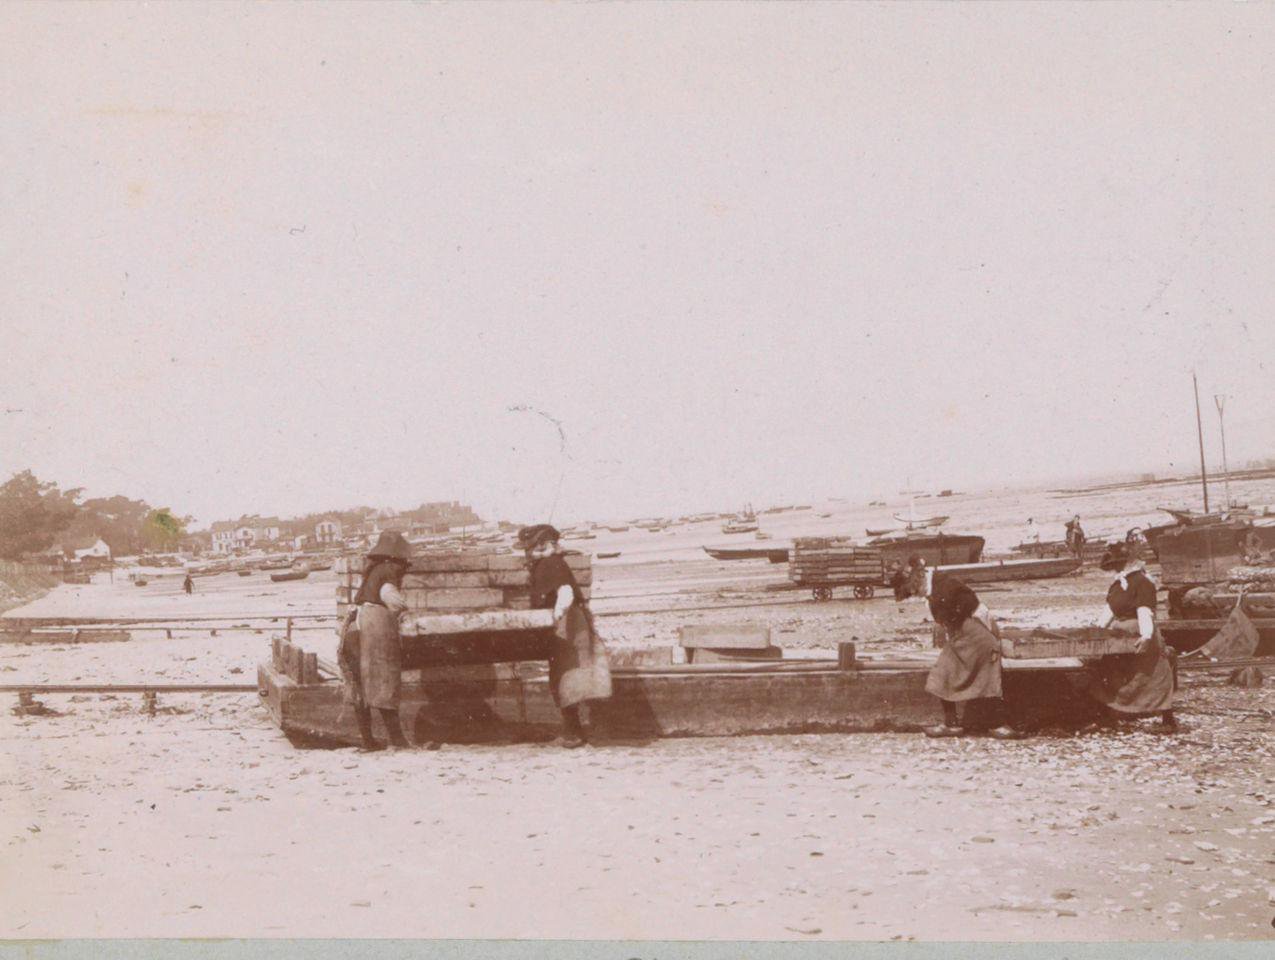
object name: photograph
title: Vissersvrouwen sjouwen (vermoedelijk) bakken met vangst op het strand bij Arcachon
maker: delizy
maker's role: manufacturer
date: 1803-1897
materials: paper, photographic support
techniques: gelatin silver print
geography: arcachon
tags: rowing-boat, canoe, etc., beach, fisherman, ships, boats on land, beached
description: Onderdeel van Fotoalbum van een Franse amateurfotograaf met opnames van uitstapjes in Frankrijk, Spanje, België, Luxemburg en Nederland, de eerste automobielen en autoraces.